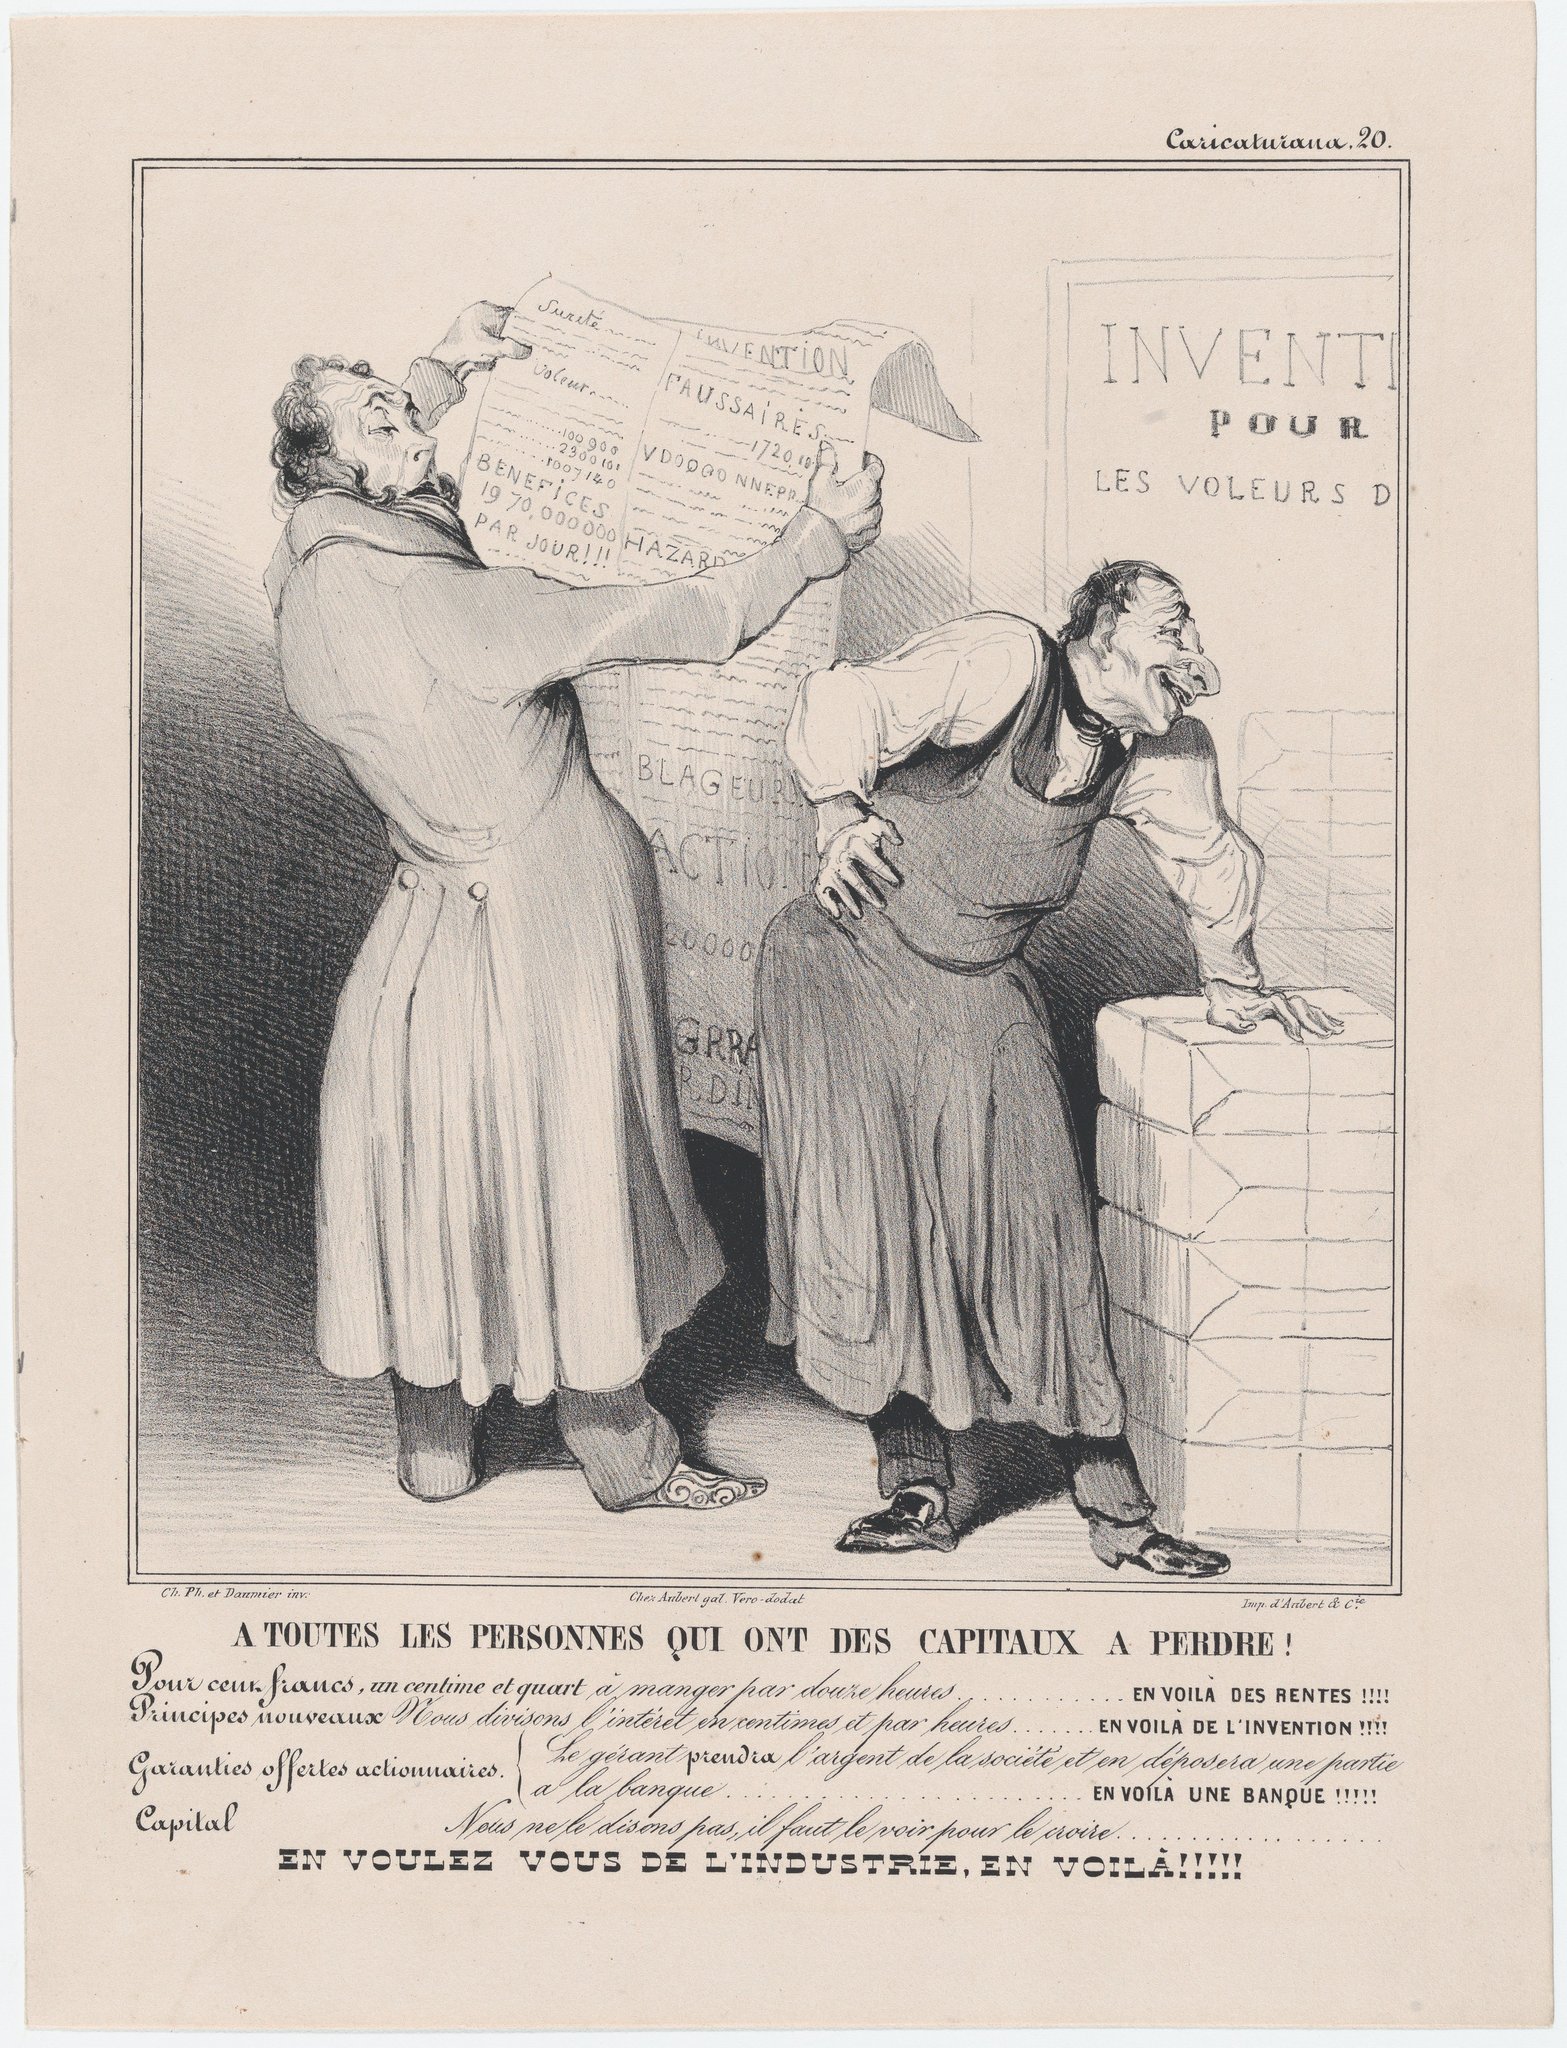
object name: print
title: Plate 20: To anyone with capital to lose, from 'Caricaturana,' published in Les Robert Macaires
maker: honoré daumier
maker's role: artist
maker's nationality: french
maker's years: 1808-1879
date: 1838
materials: paper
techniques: lithograph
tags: satire,men